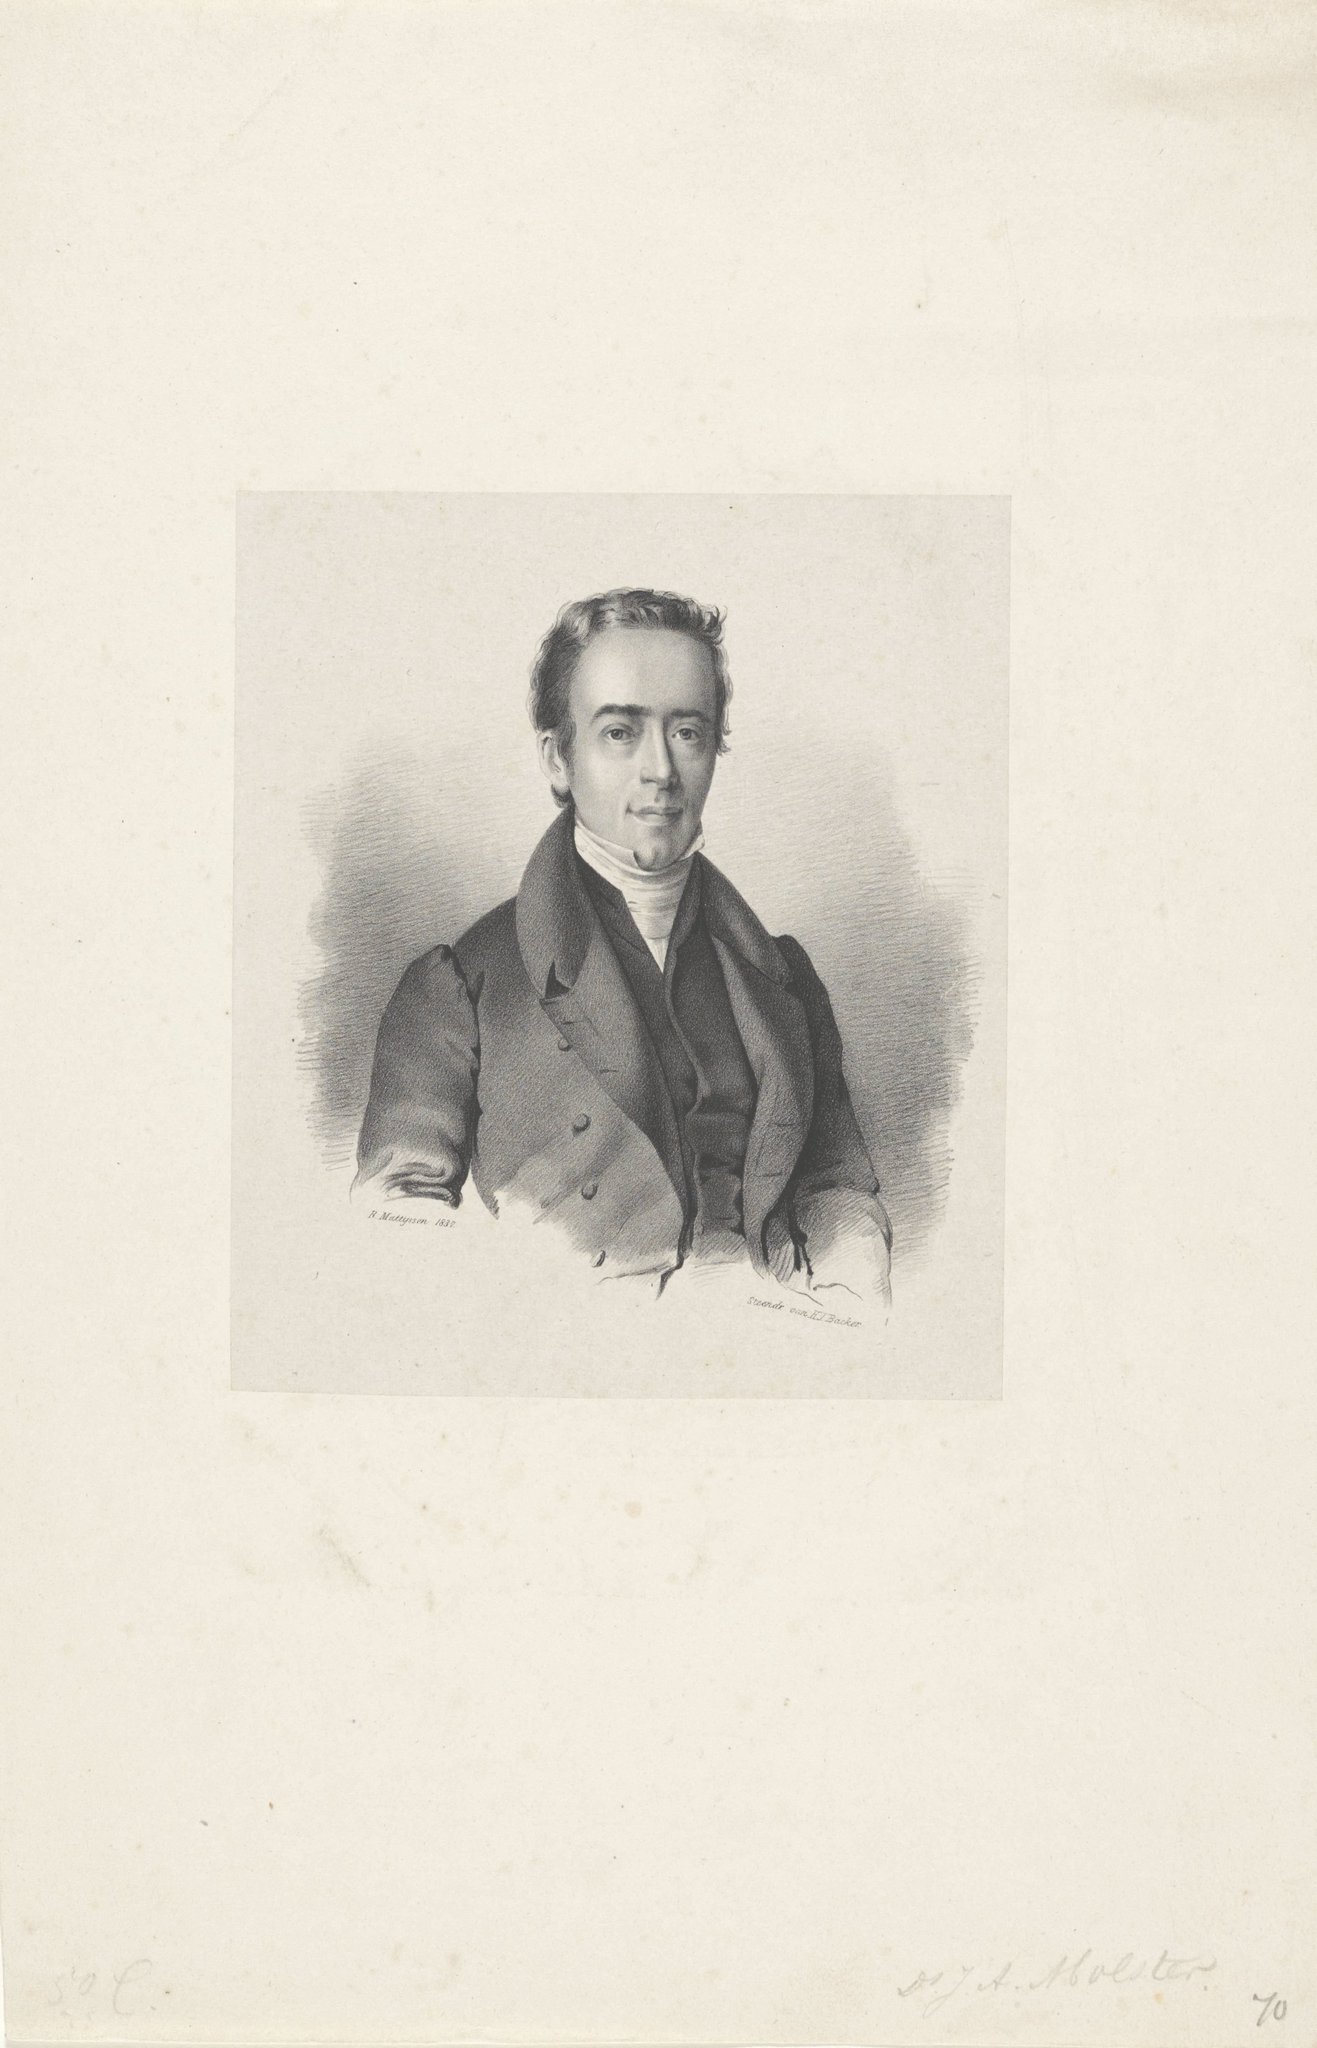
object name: print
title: Portret van Johannes Abraham Dederiks Molster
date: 1837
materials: paper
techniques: lithograph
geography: netherlands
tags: amsterdam, historical persons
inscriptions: collector's mark: Lugt 2228